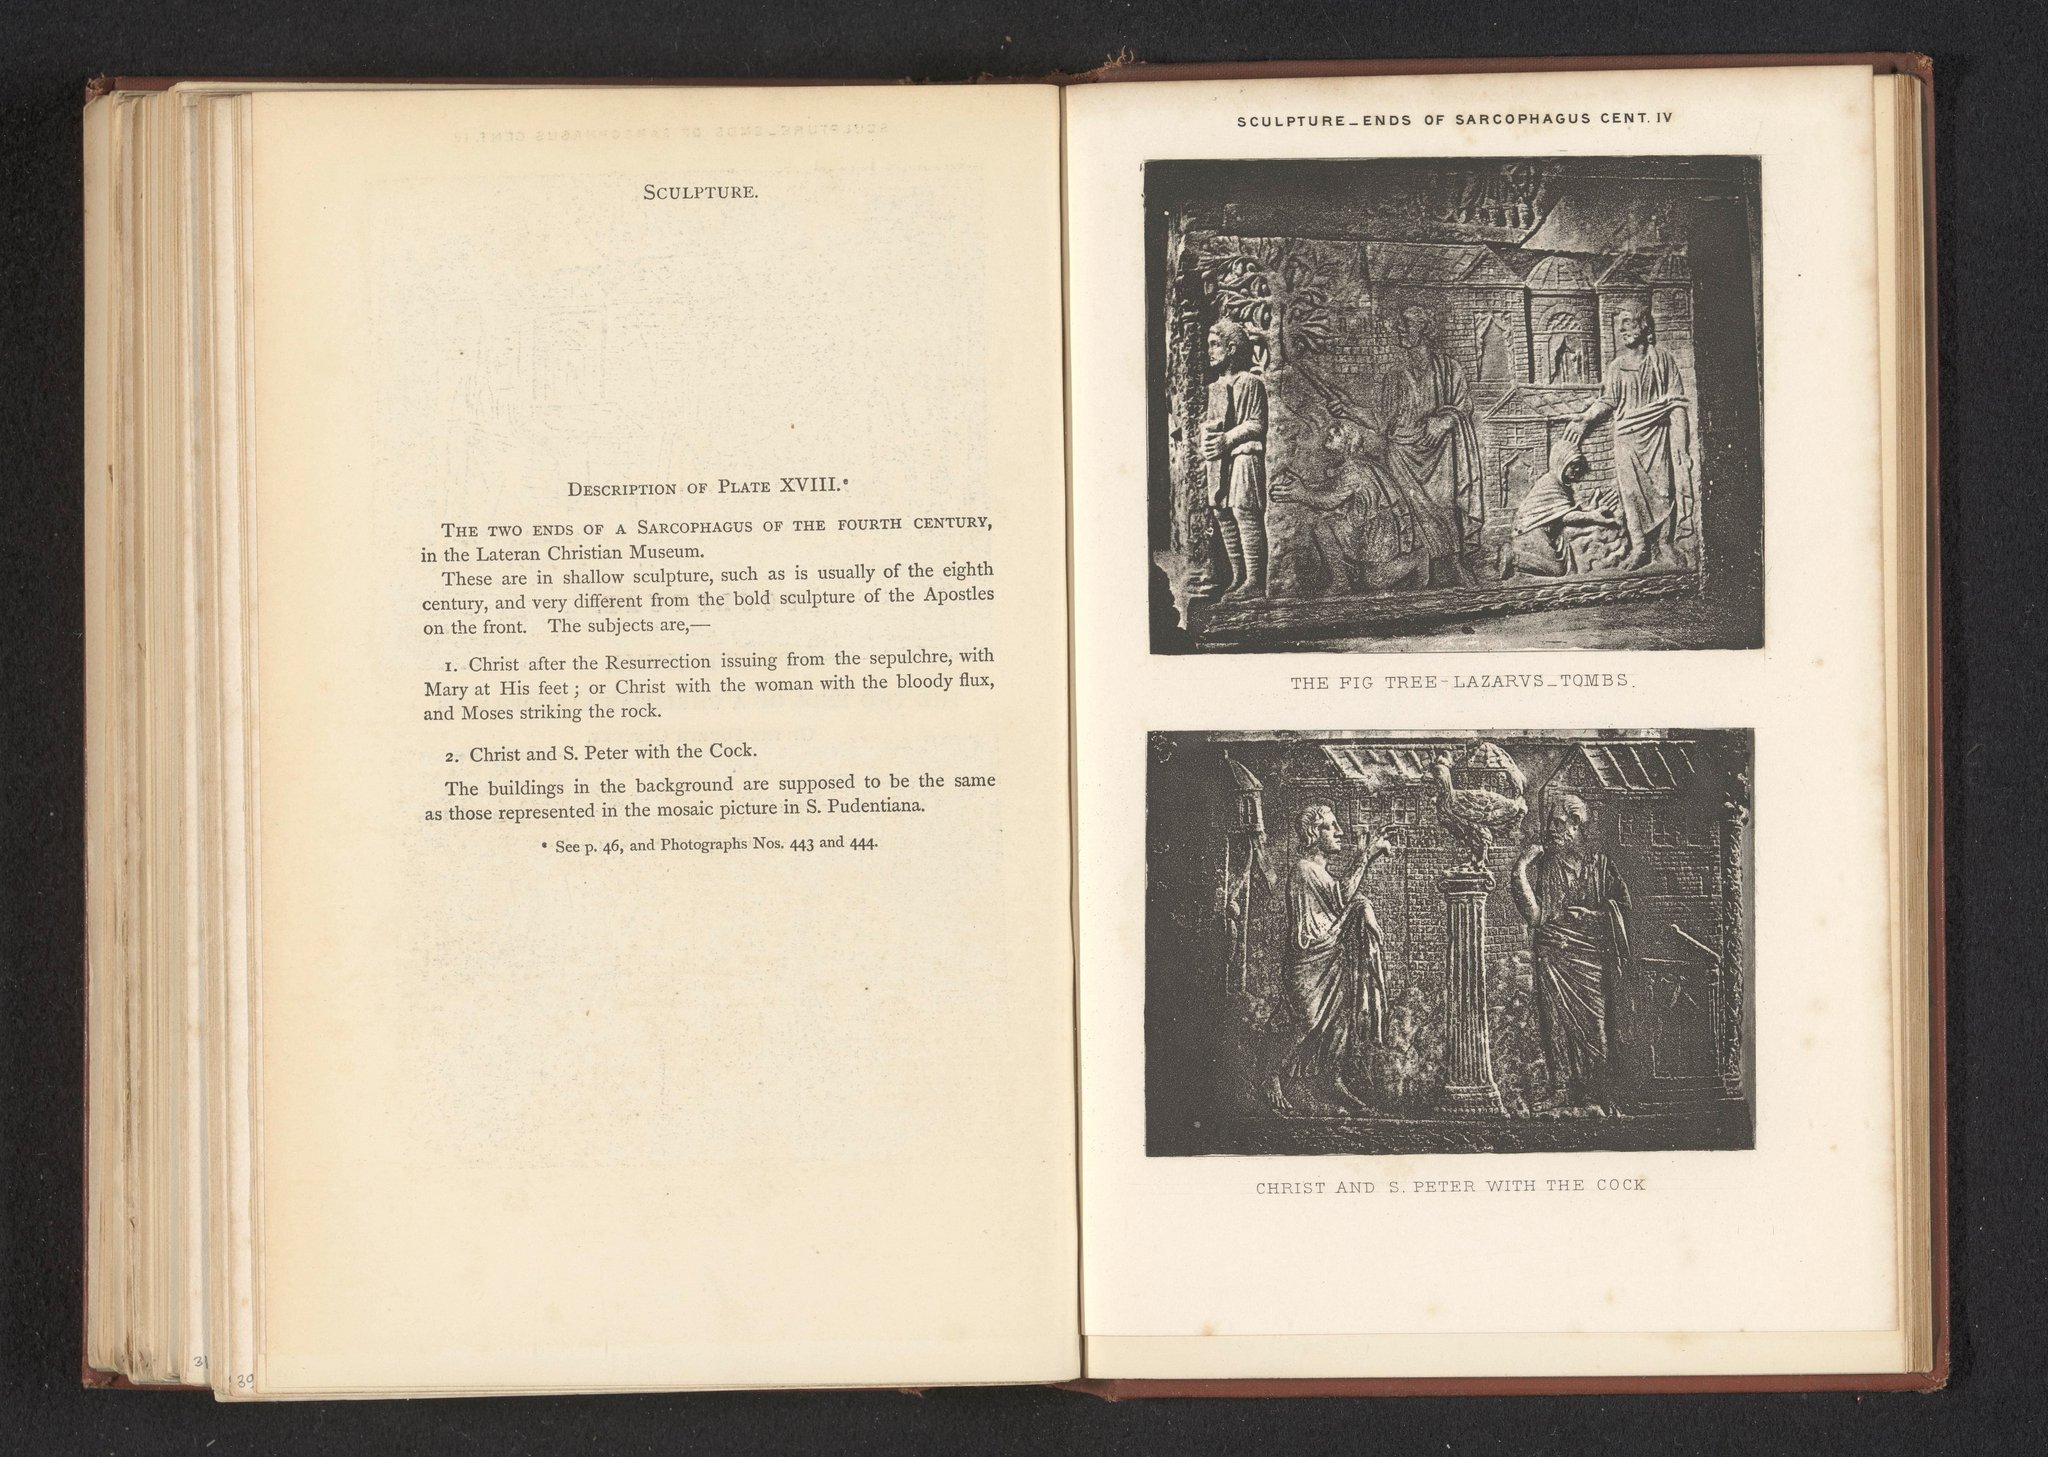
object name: page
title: Twee reliëfs van sarcofagen, voorstellend Lazarus bij een vijgenboom en Christus en Petrus bij de haan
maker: Anonymous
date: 1867-1877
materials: paper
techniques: photoaquatint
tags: the raising of lazarus ('lazarus, come out'), sarcophagus, decorating 'en relief', appliquéing, cock on column ~ instruments of the passion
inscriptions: inscription: ‘The fig tree - Lazarus- tombs. Christ and S. Peter with the cock’